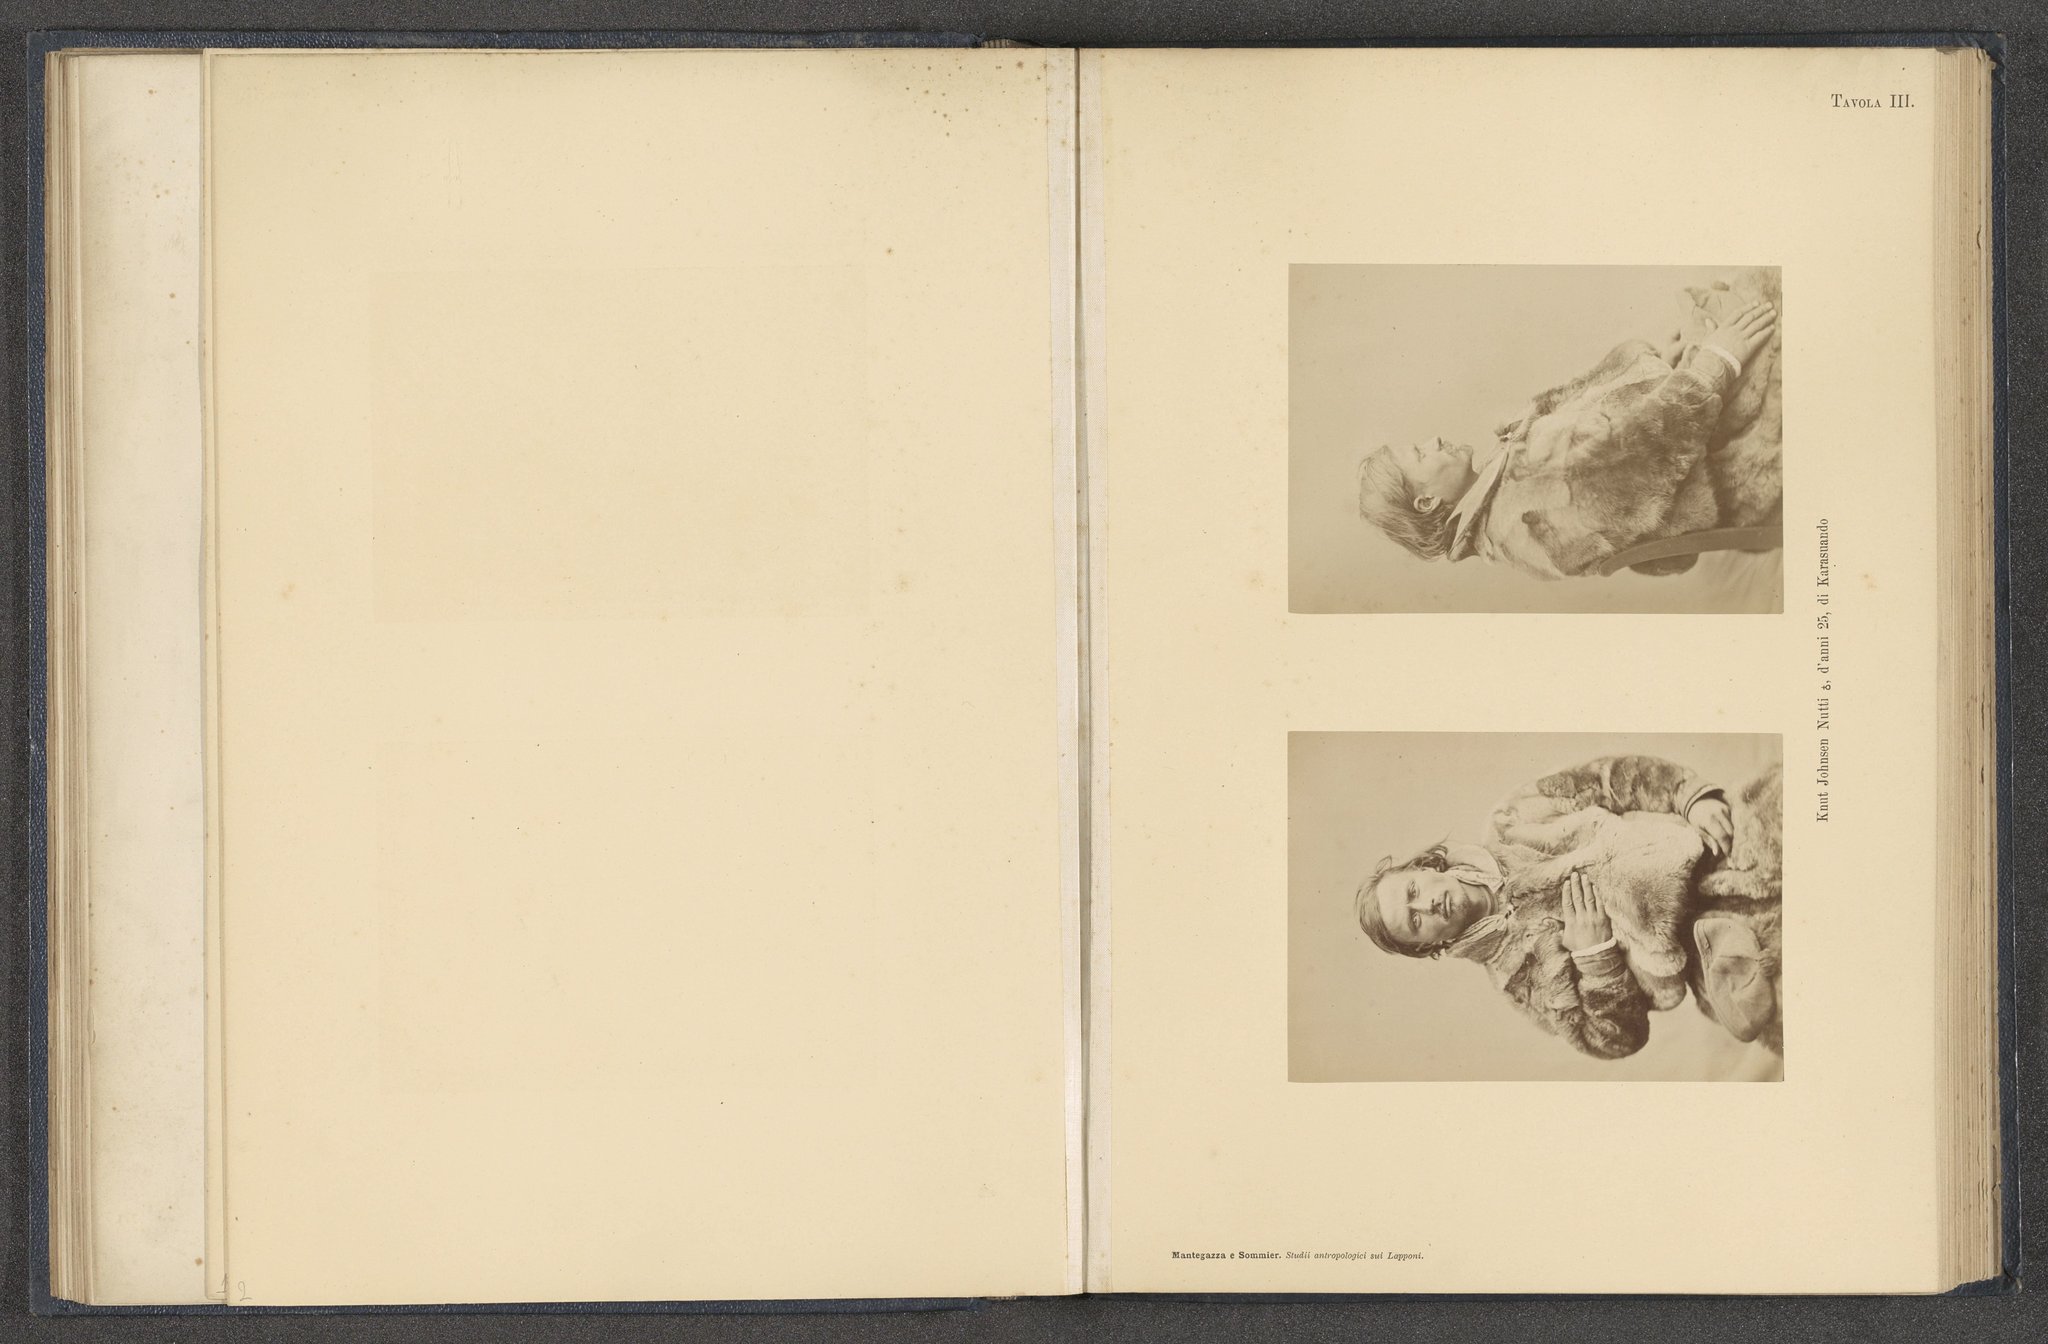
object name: page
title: Twee portretten van Knut Johnsen Nutti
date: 1870-1880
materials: paper, photographic support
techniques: albumen print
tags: adult man (+ front view), adult man (+ sideview, profile), fashion, clothing (+ fur used for clothes)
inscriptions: number: ‘Tavola III.’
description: Links een vooraanzicht, rechts een zijaanzicht.